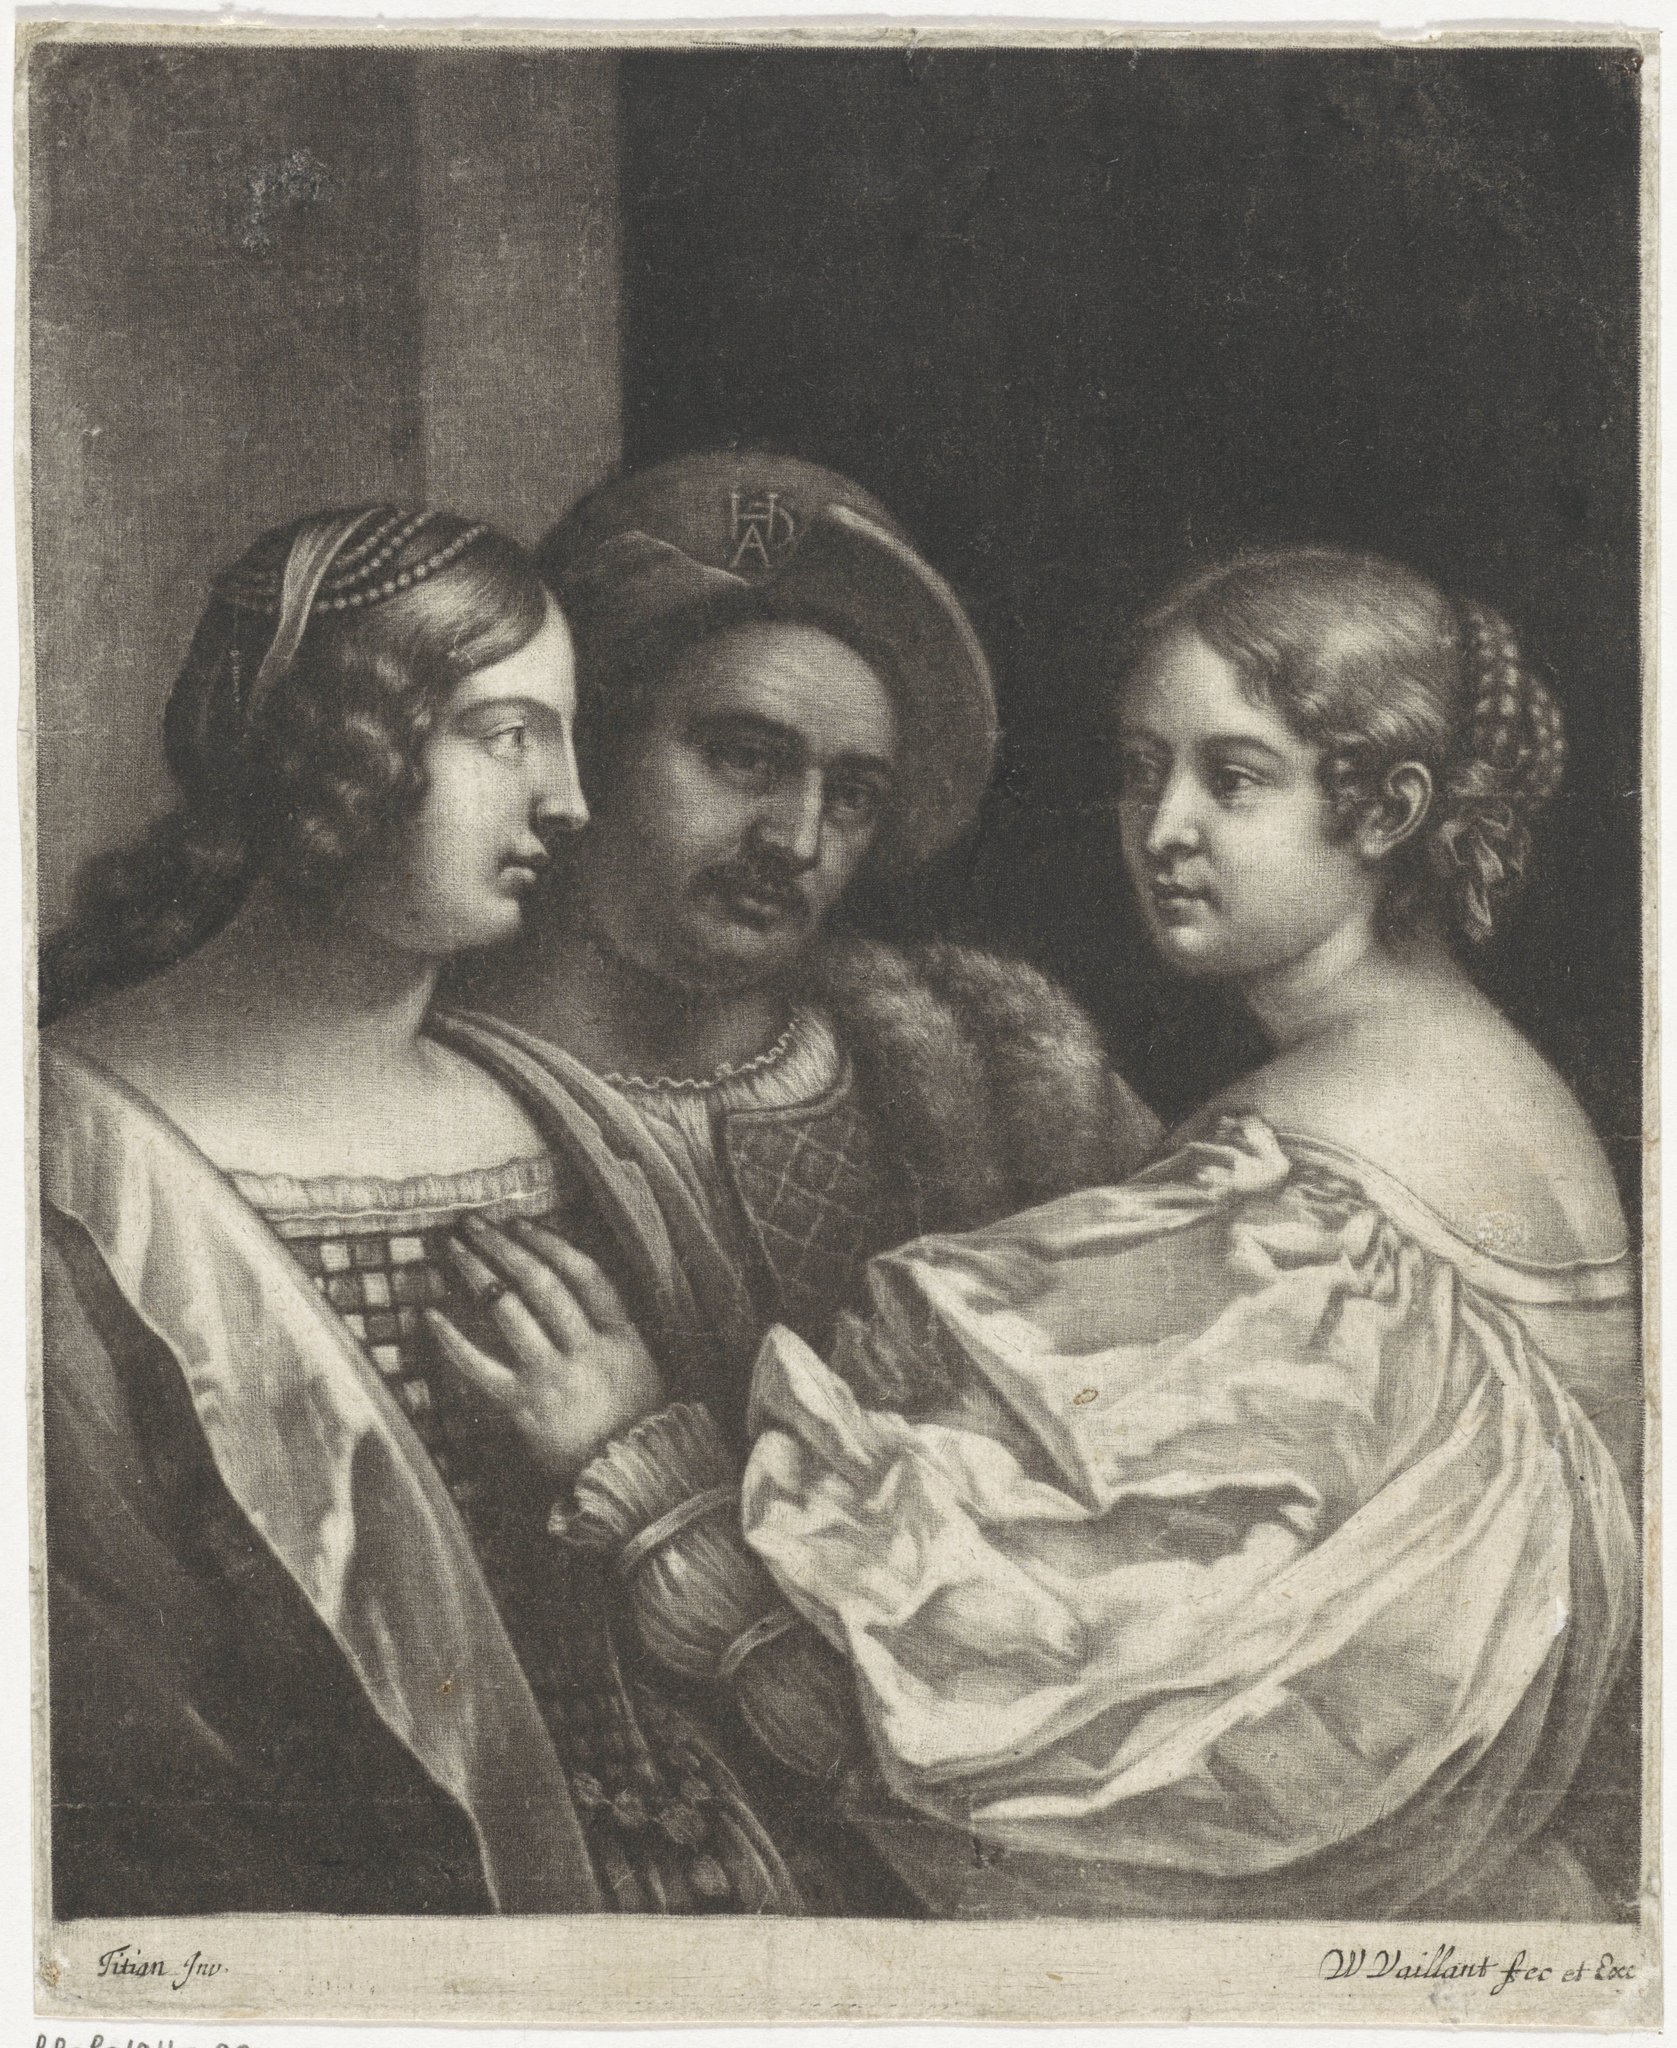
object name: print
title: Twee vrouwen en een man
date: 1658-1677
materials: paper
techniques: mezzotint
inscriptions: collector's mark: Lugt 514, collector's mark: Lugt 2036, collector's mark: Lugt 2228